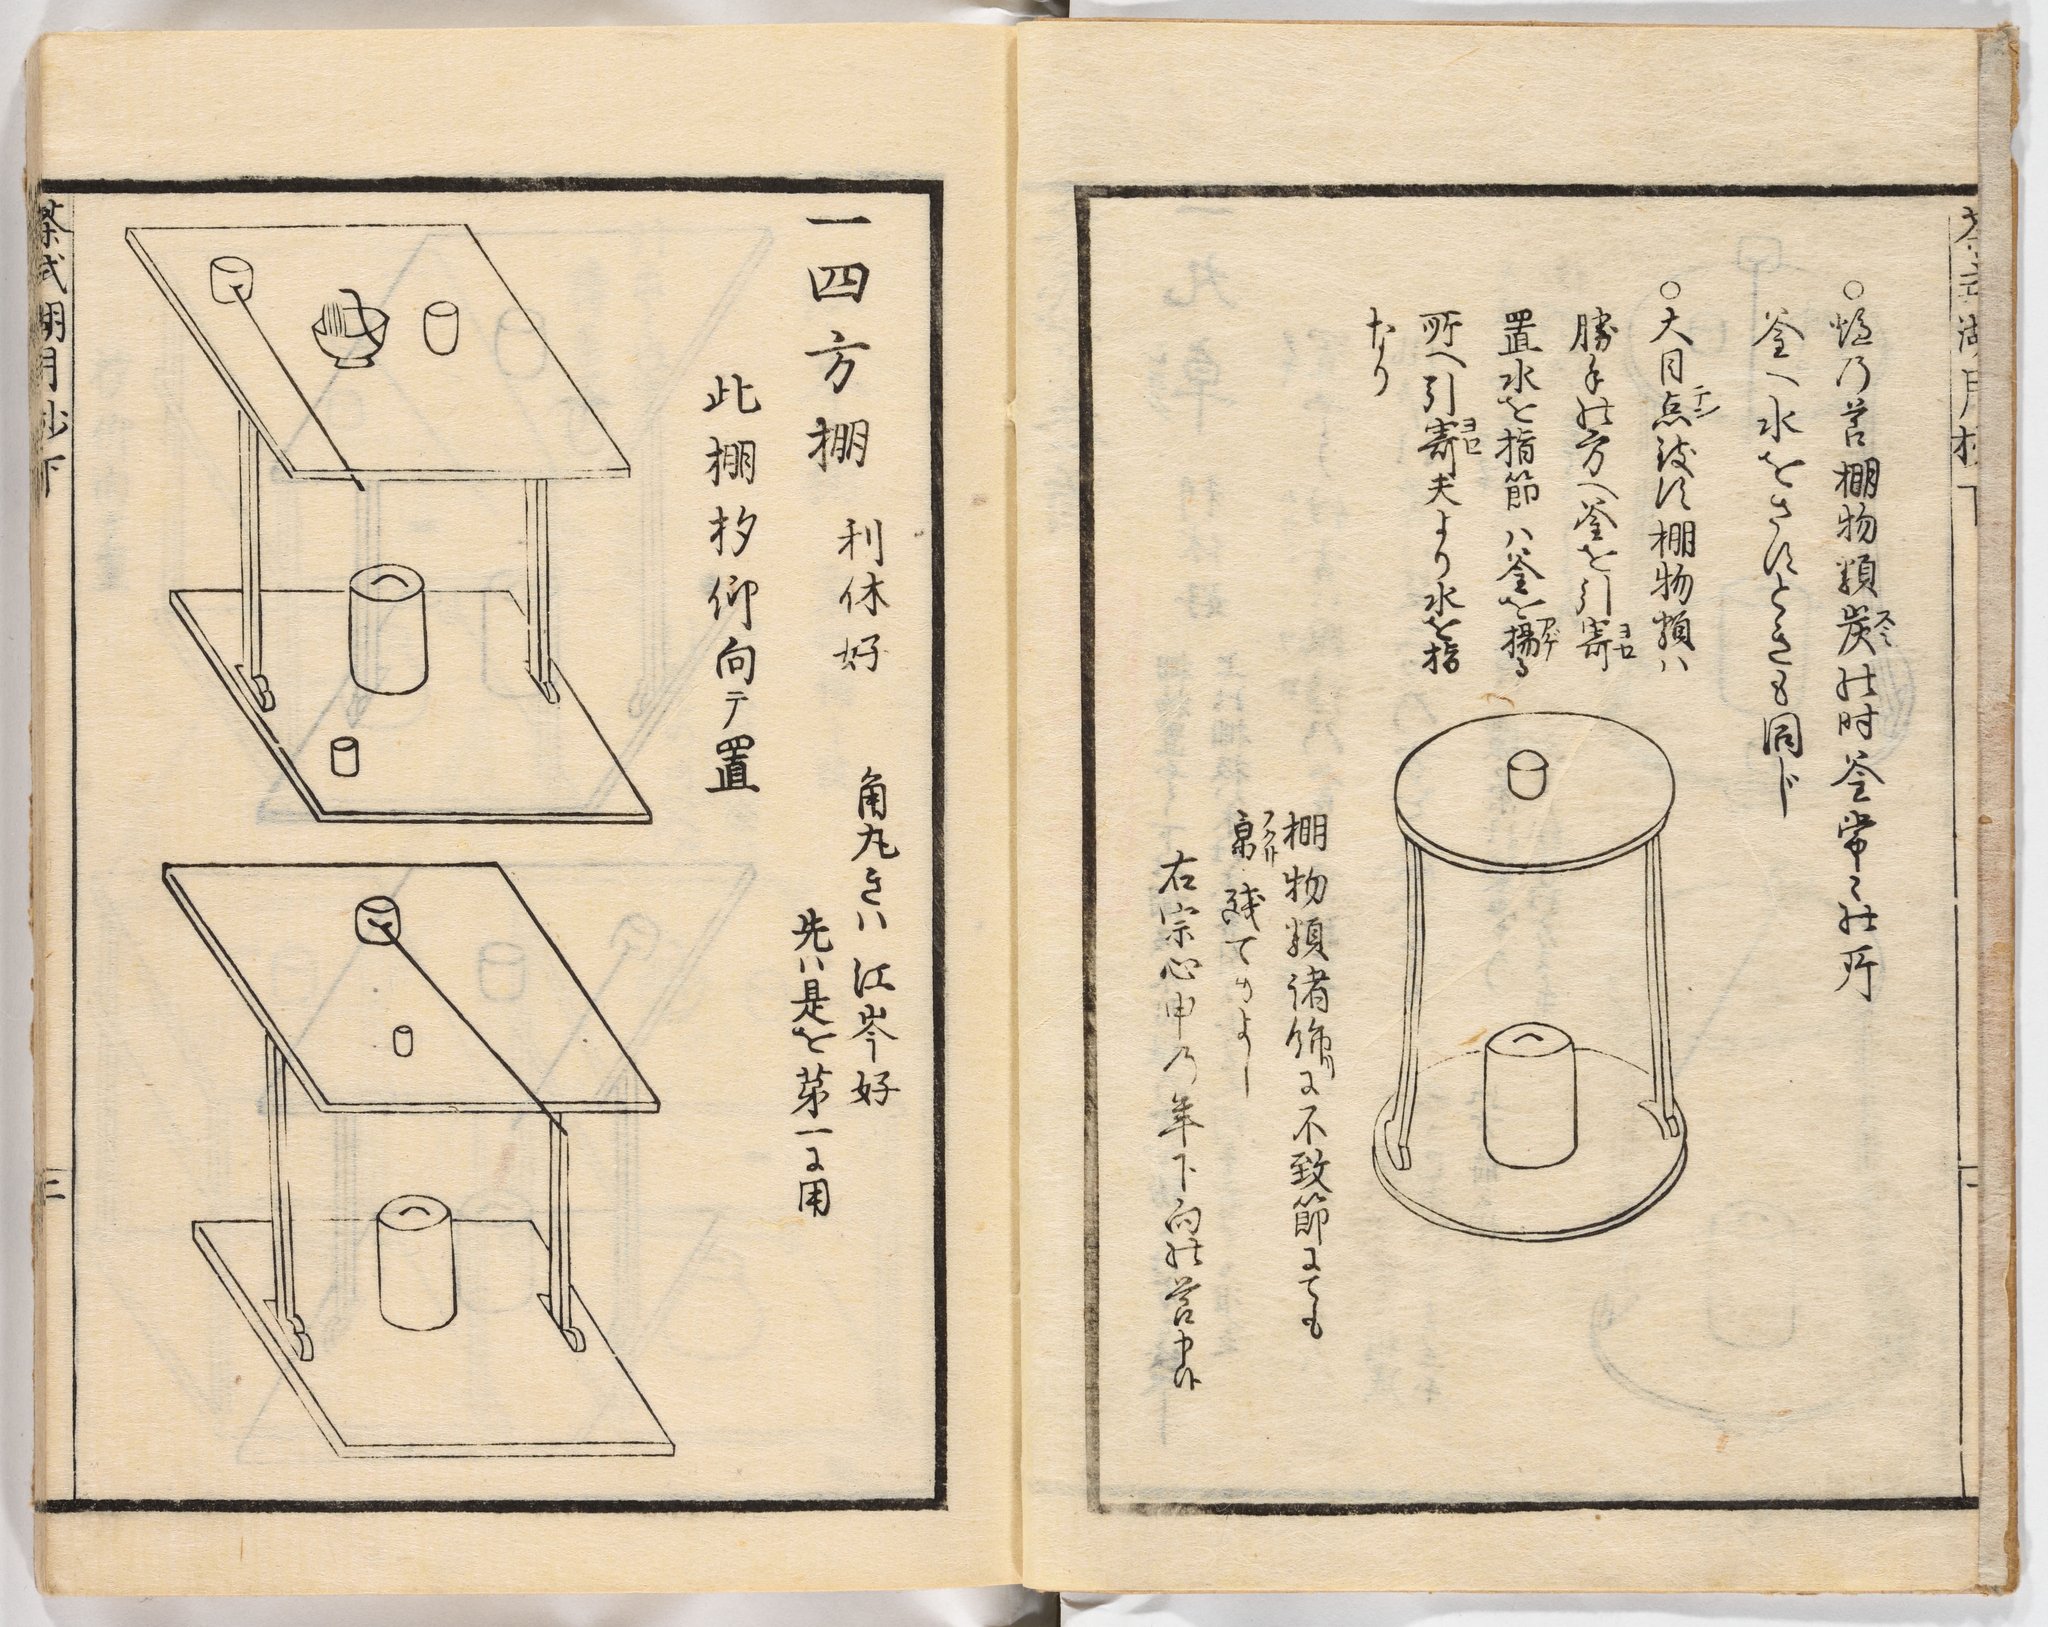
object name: illustrated book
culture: japanese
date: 1893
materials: ink, paper